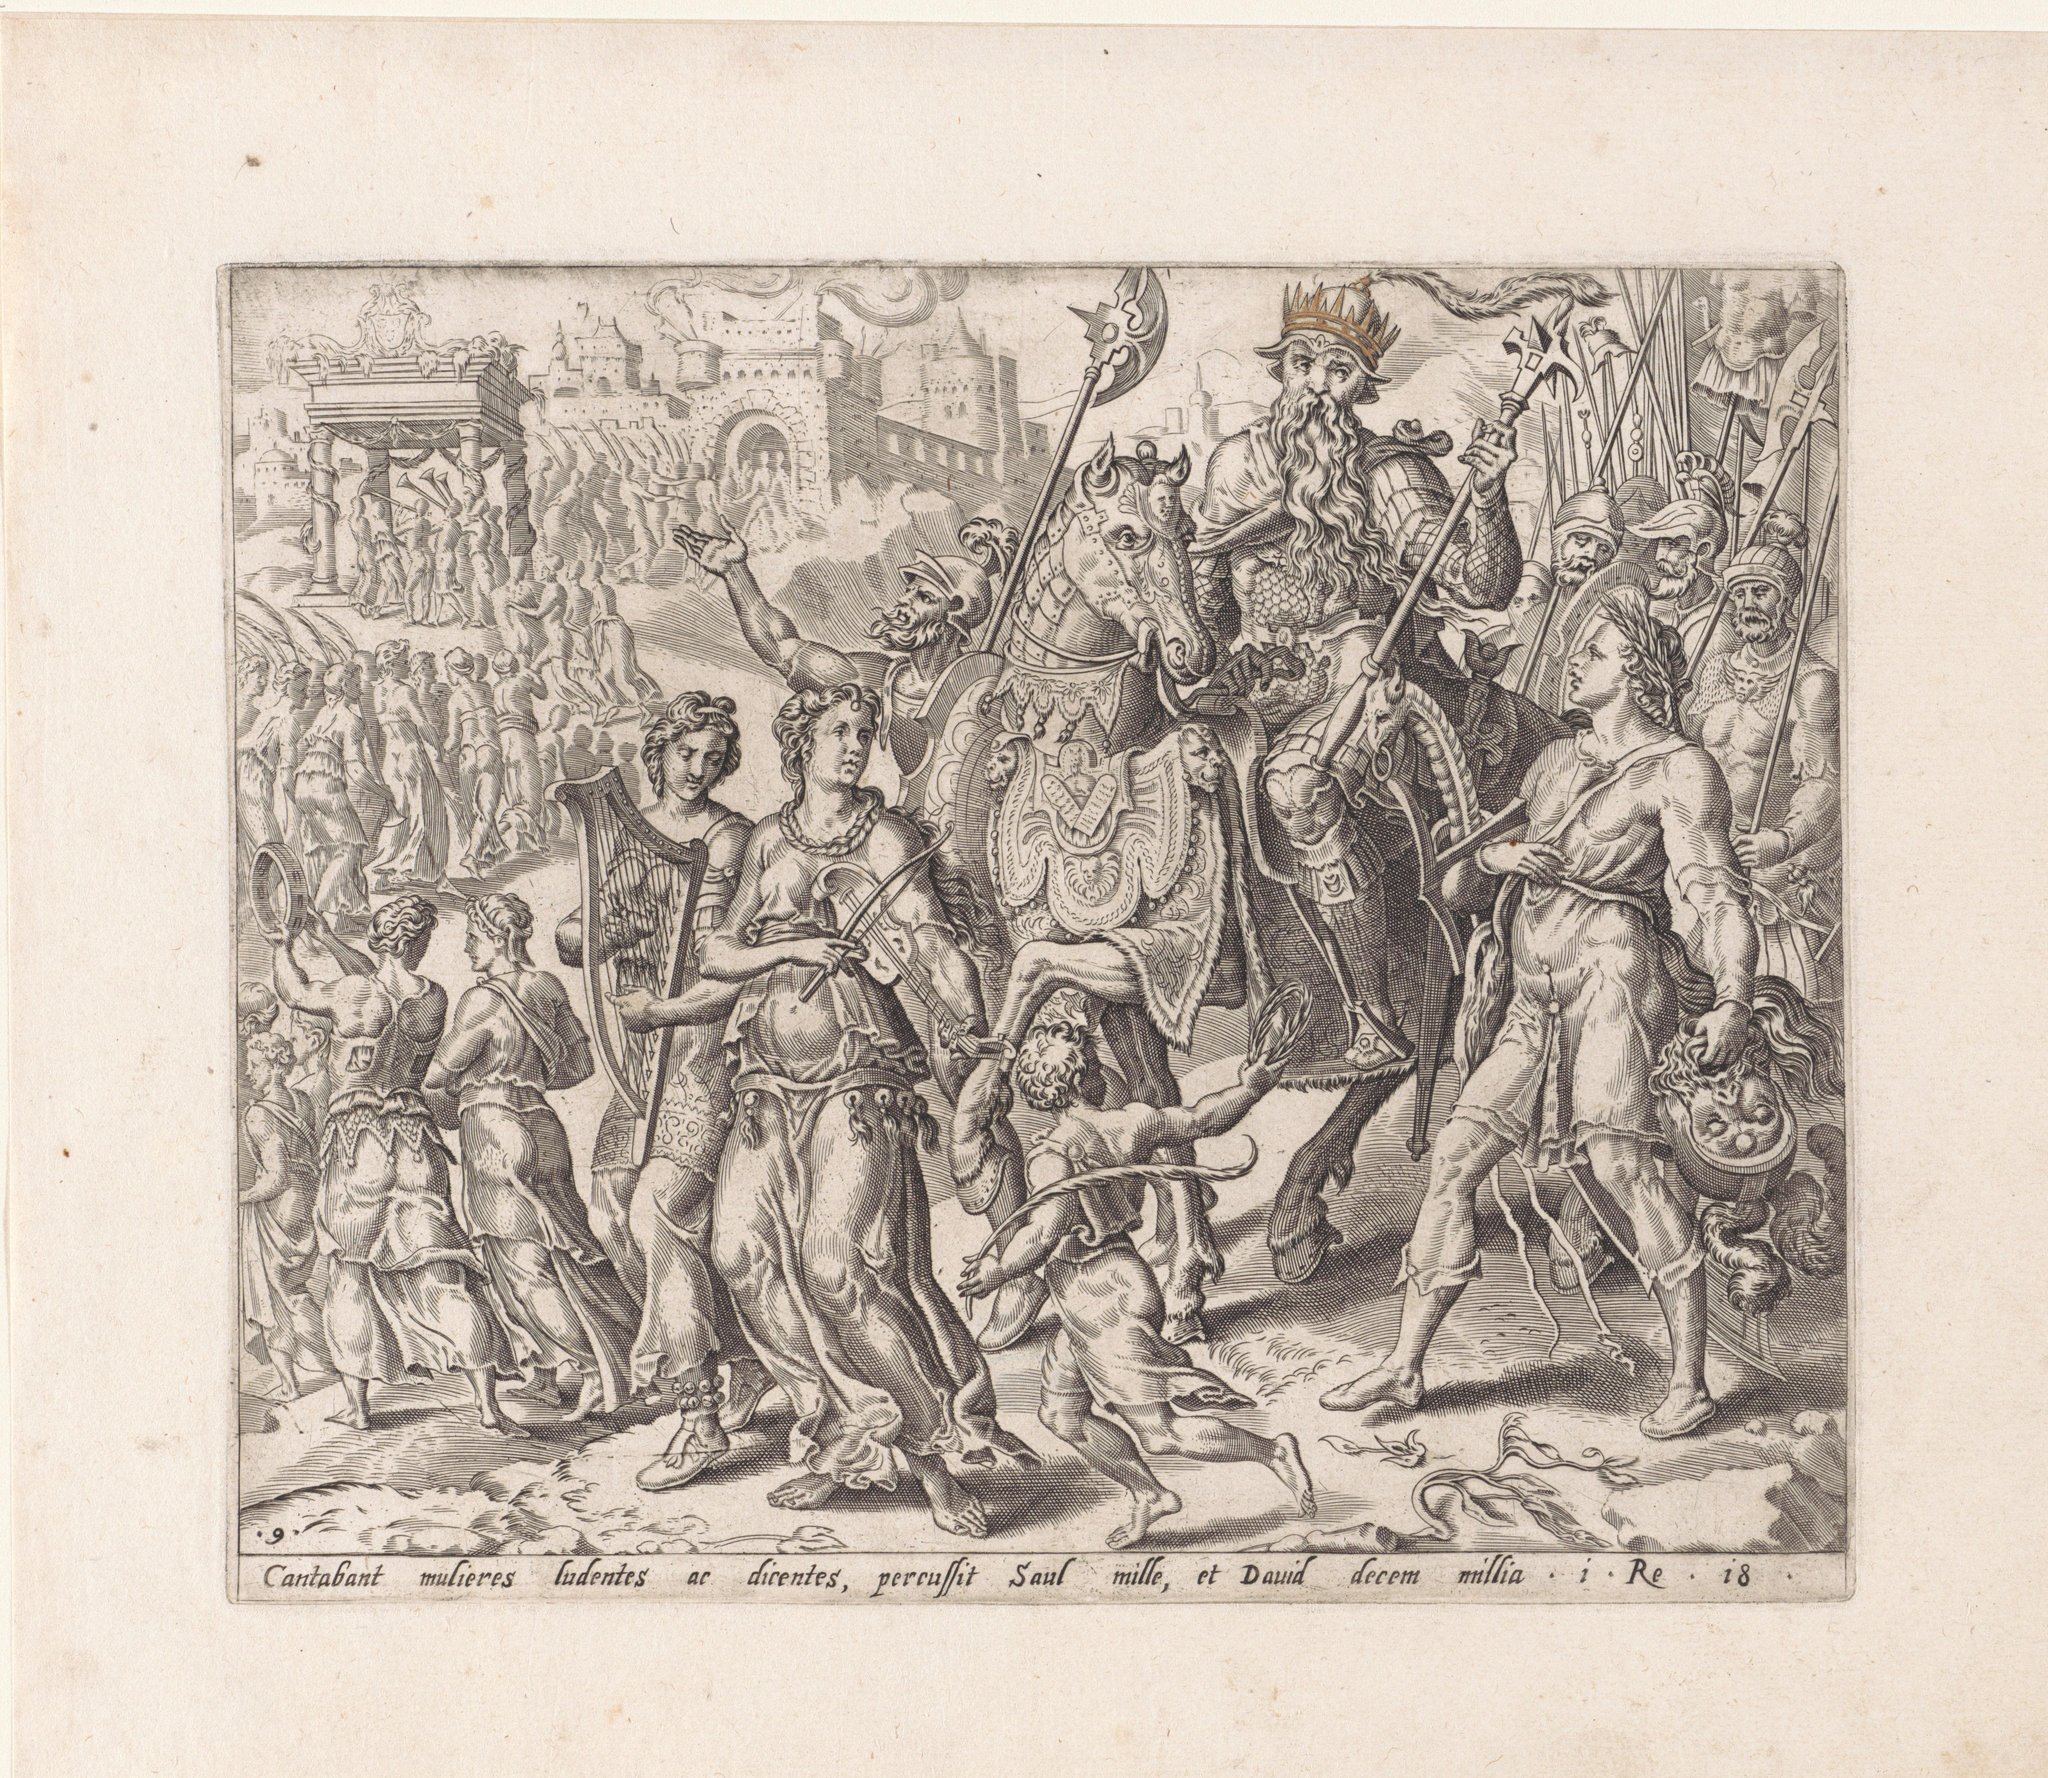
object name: print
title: Triomferende David met het hoofd van Goliat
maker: Anonymous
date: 1555-1633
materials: paper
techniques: engraving, hand coloring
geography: low countries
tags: david's triumph: the women of israel come out to welcome david, singing, dancing, and playing tambourines and lyres; david holding the head of goliath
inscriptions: collector's mark: Lugt 2228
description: David loopt met het hoofd van Goliat in de hand naast Saul in de triomfstoet. Voor hen musicerende vrouwen en mensen met palmtakken. Achter hen soldaten. In de marge een éénregelig onderschrift in het Latijn uit 1 Sam. (foutief aangeduid als 1 Koningen op de prent).